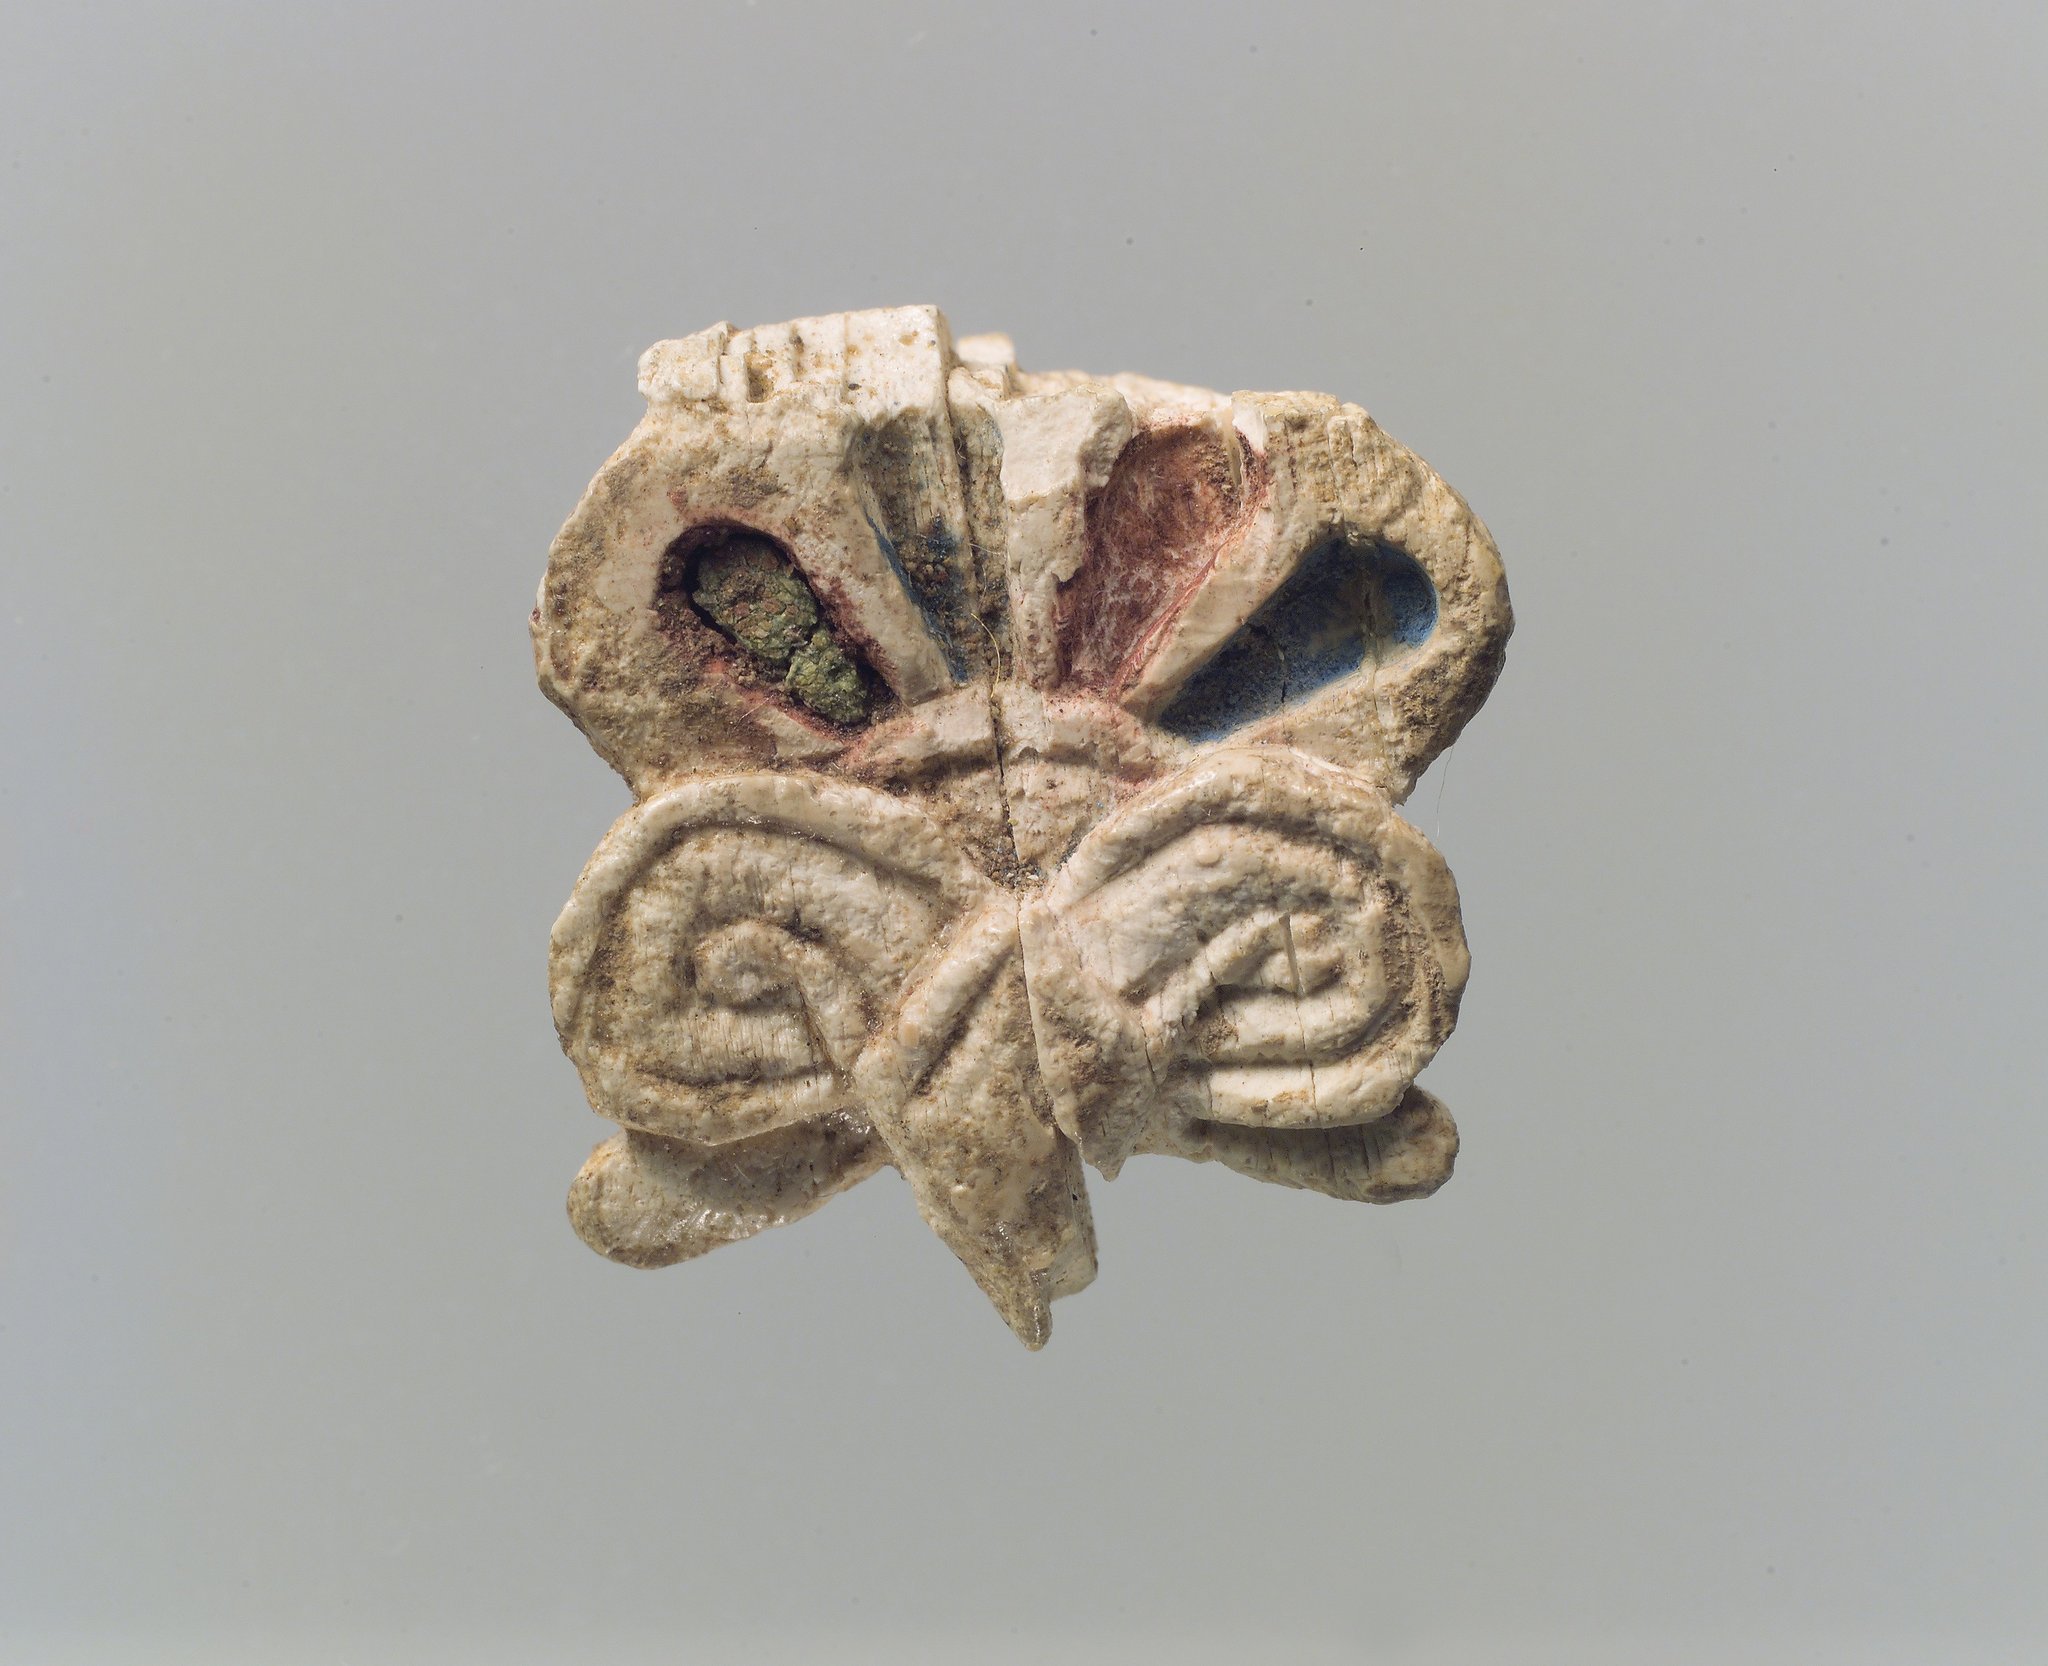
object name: relief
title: Plaque fragment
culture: assyrian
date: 800-601 BCE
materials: ivory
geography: mesopotamia